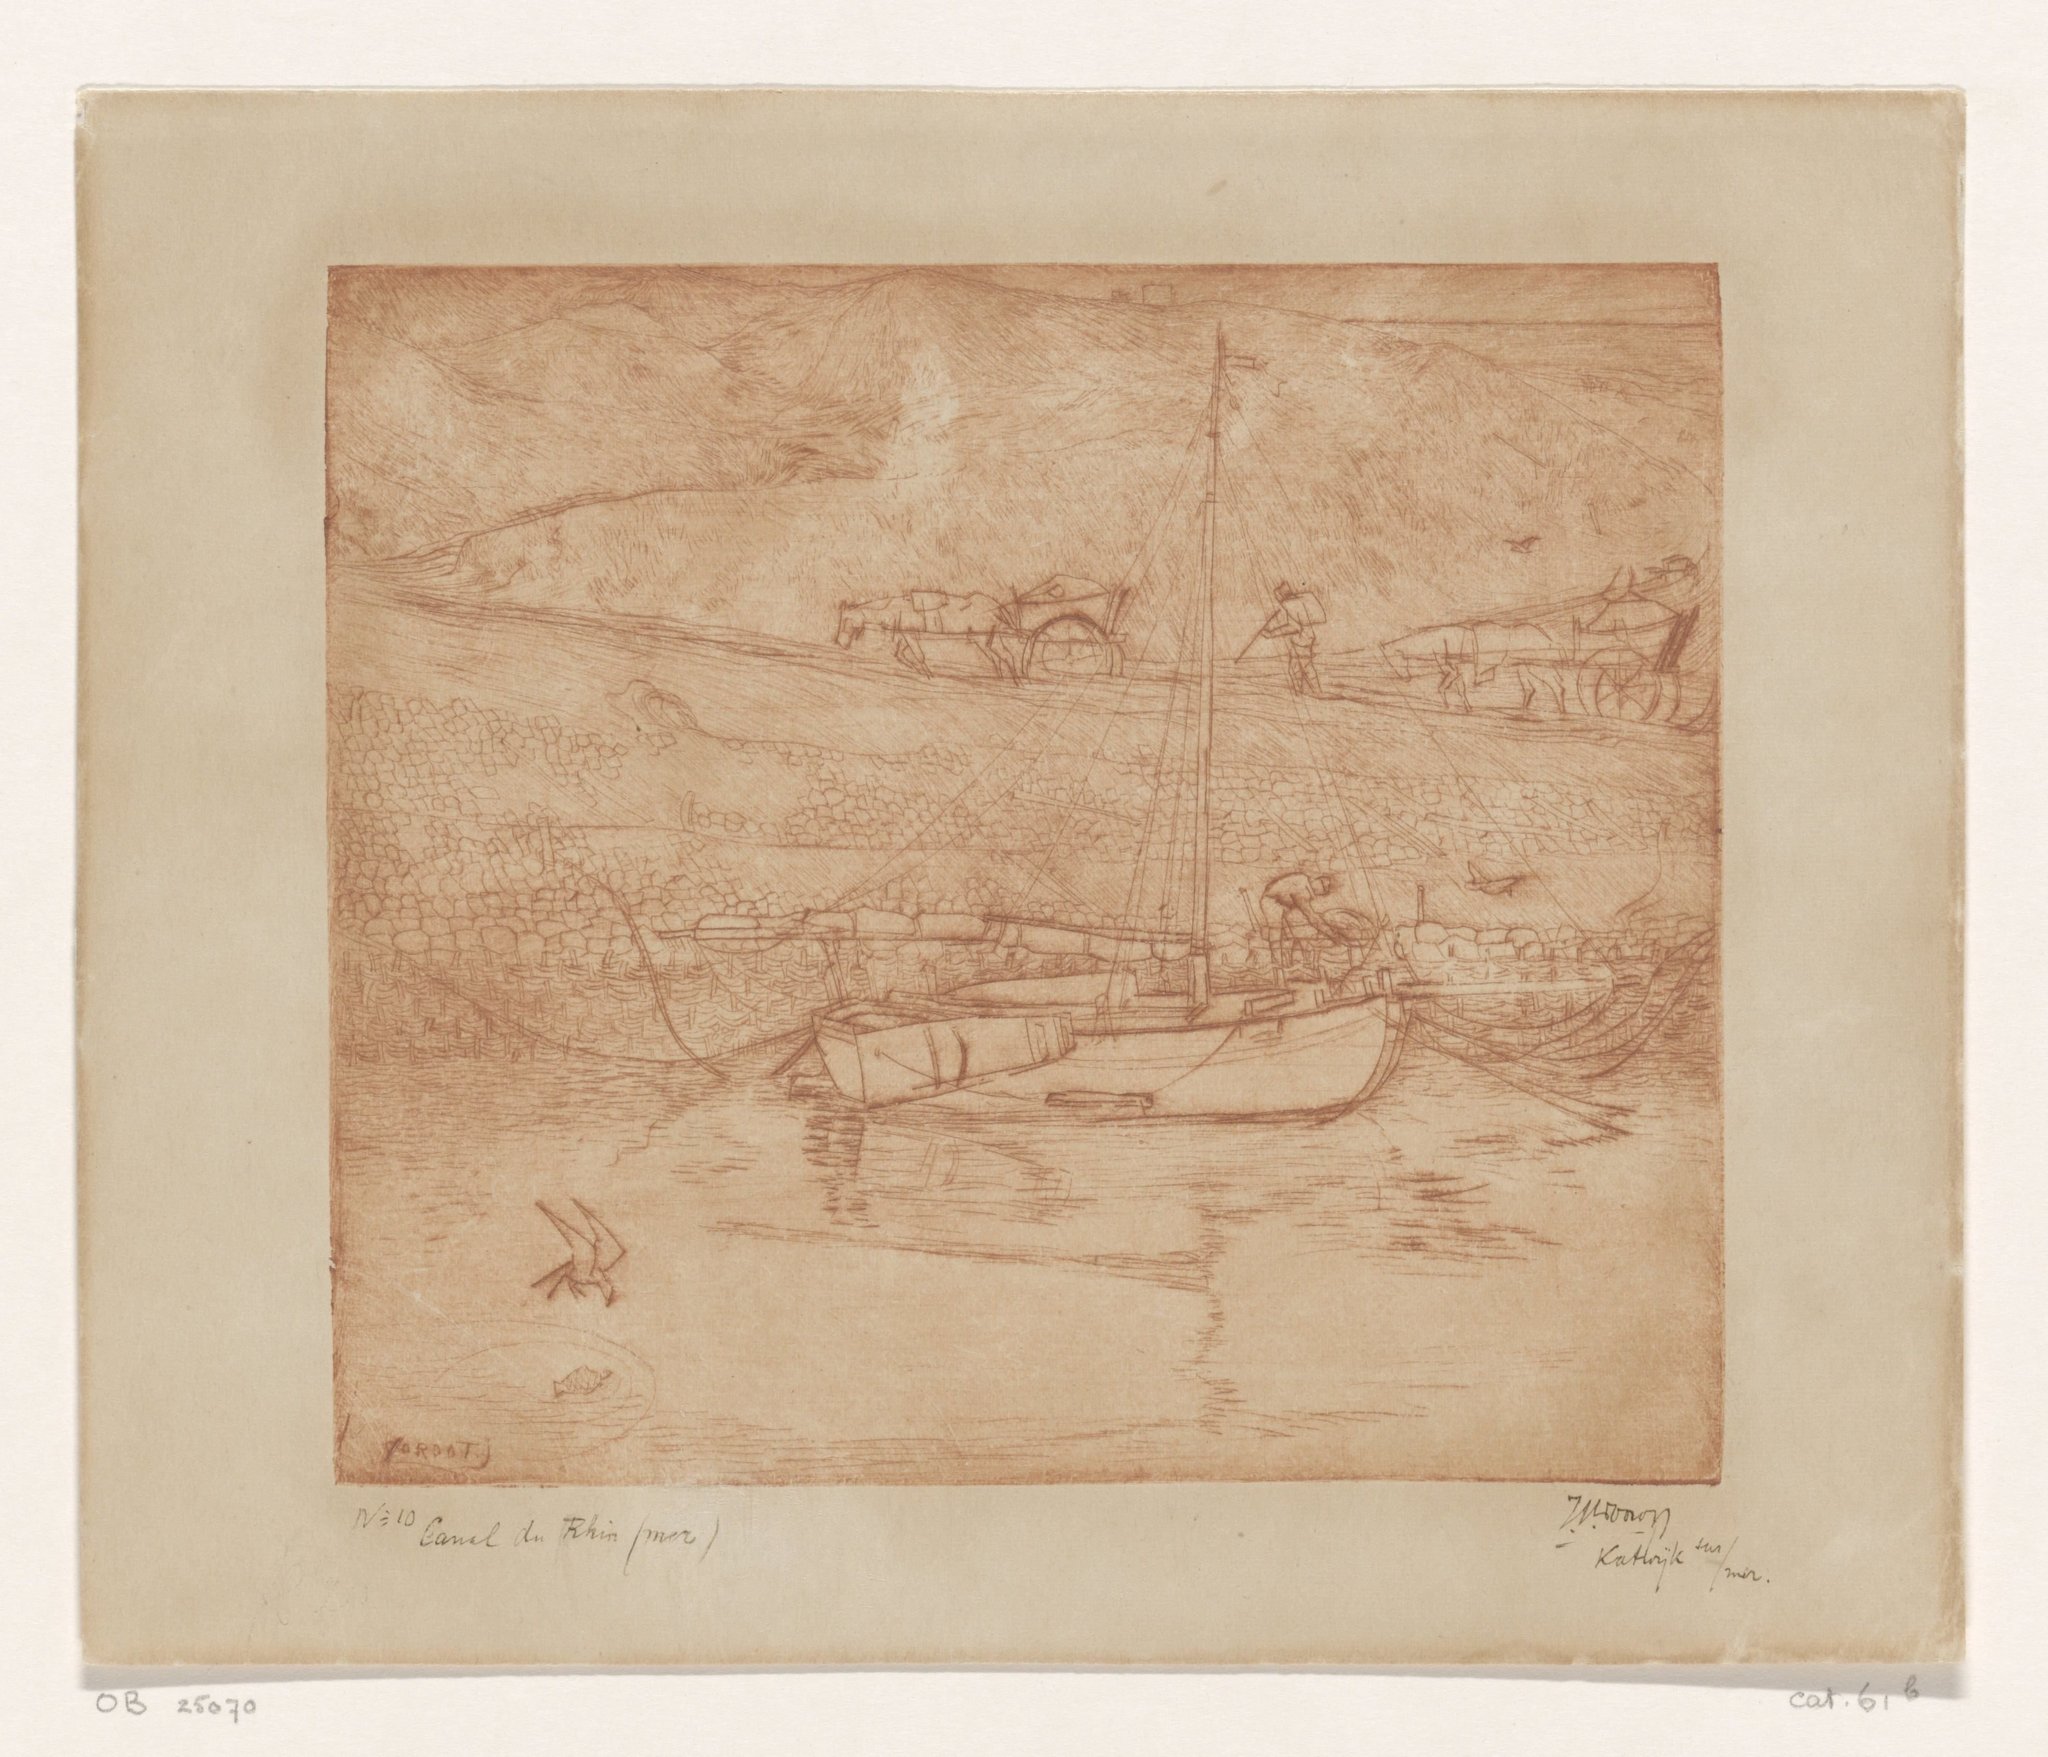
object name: print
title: Kanaal bij Katwijk aan Zee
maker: jan toorop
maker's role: draughtsman, painter, print maker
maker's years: 1858-1928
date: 1901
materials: paper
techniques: drypoint, intaglio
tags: dune coast, sailing-ship, sailing-boat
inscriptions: collector's mark: Lugt 2228, annotation: ‘N10 Canal du Rhin / mer’, collector's mark: Lugt 2760, annotation: ‘J. Th. Toorop/ Katwijk sur/mer’